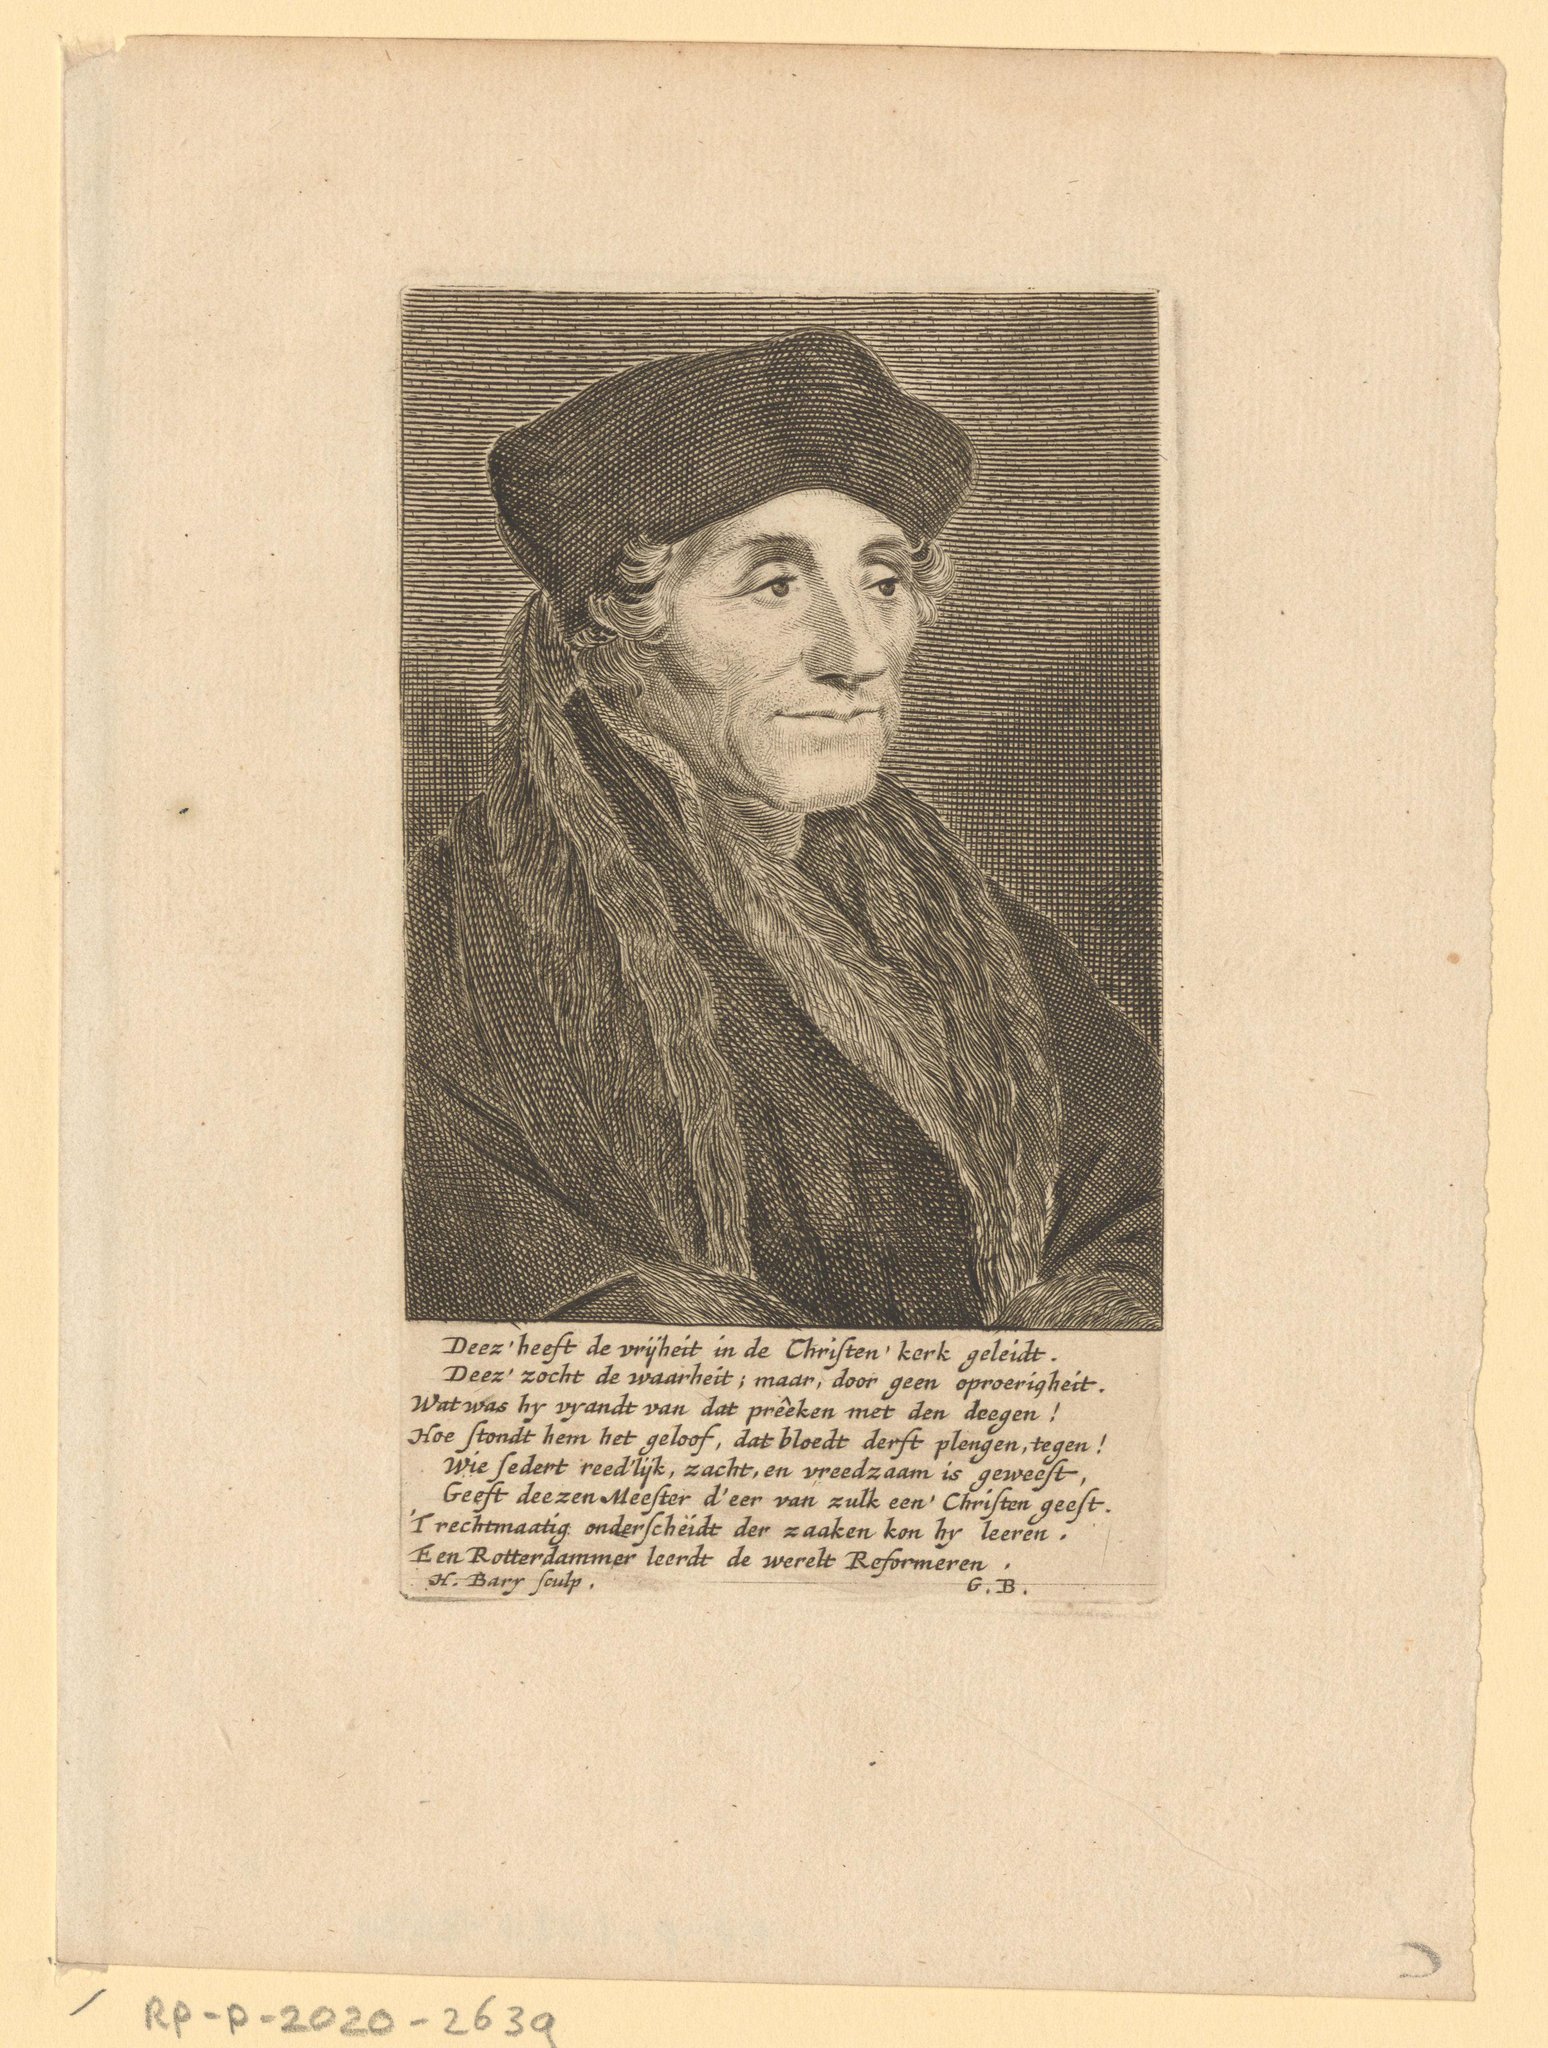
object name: print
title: Portret van Desiderius Erasmus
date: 1671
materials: paper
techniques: engraving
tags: rotterdam, desiderius erasmus, historical persons, scholar, philosopher (+ portrait of scholar, scientist)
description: Prent waarschijnlijk uit: G. Brandts Historie der Reformatie (...). Amsterdam: Jan Rieuwertsz., Hendrik en Dirk Boom, 1671.